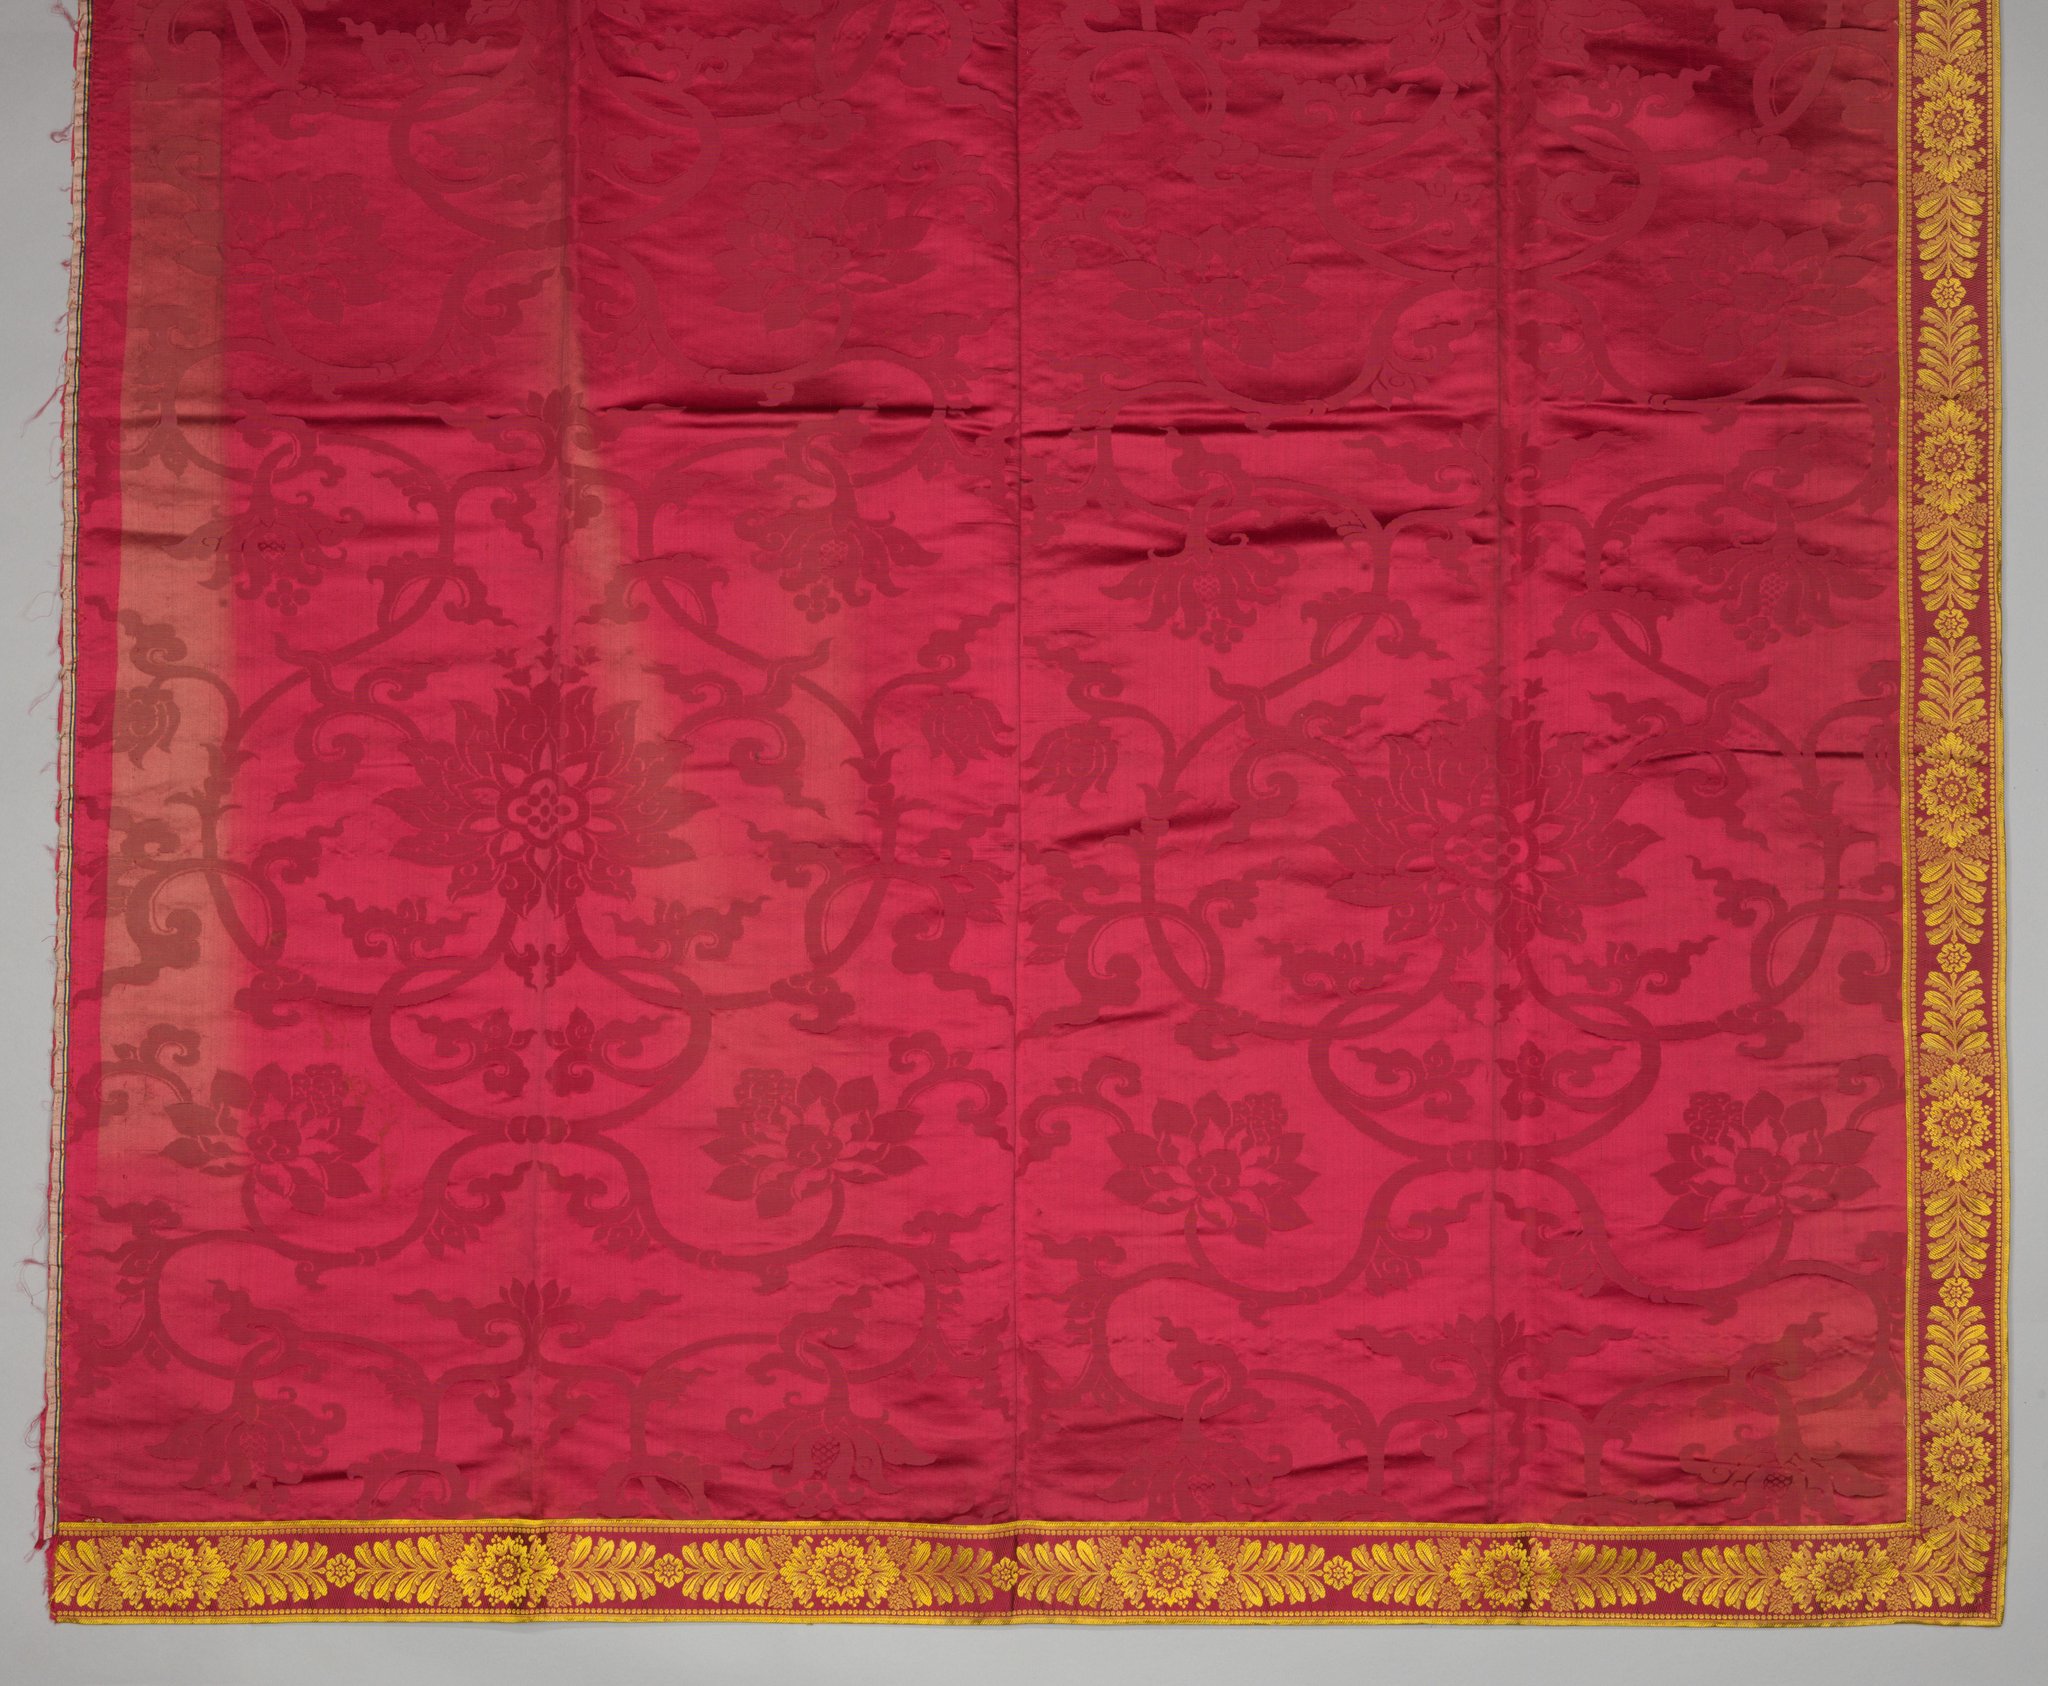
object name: fragment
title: Fragment van gordijn van rood zijdedamast met een Chinees patroon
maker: Anonymous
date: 1830-1870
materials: silk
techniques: damask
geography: china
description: Fragment van gordijn van rood zijdedamast met Chinees patroon met krullende takken met bladeren en bloemen. Zonder ringen, slechts één verticale boord (gordijn over hele lengte gedeeltelijk afgetornd). Gevoerd met rode zijde.